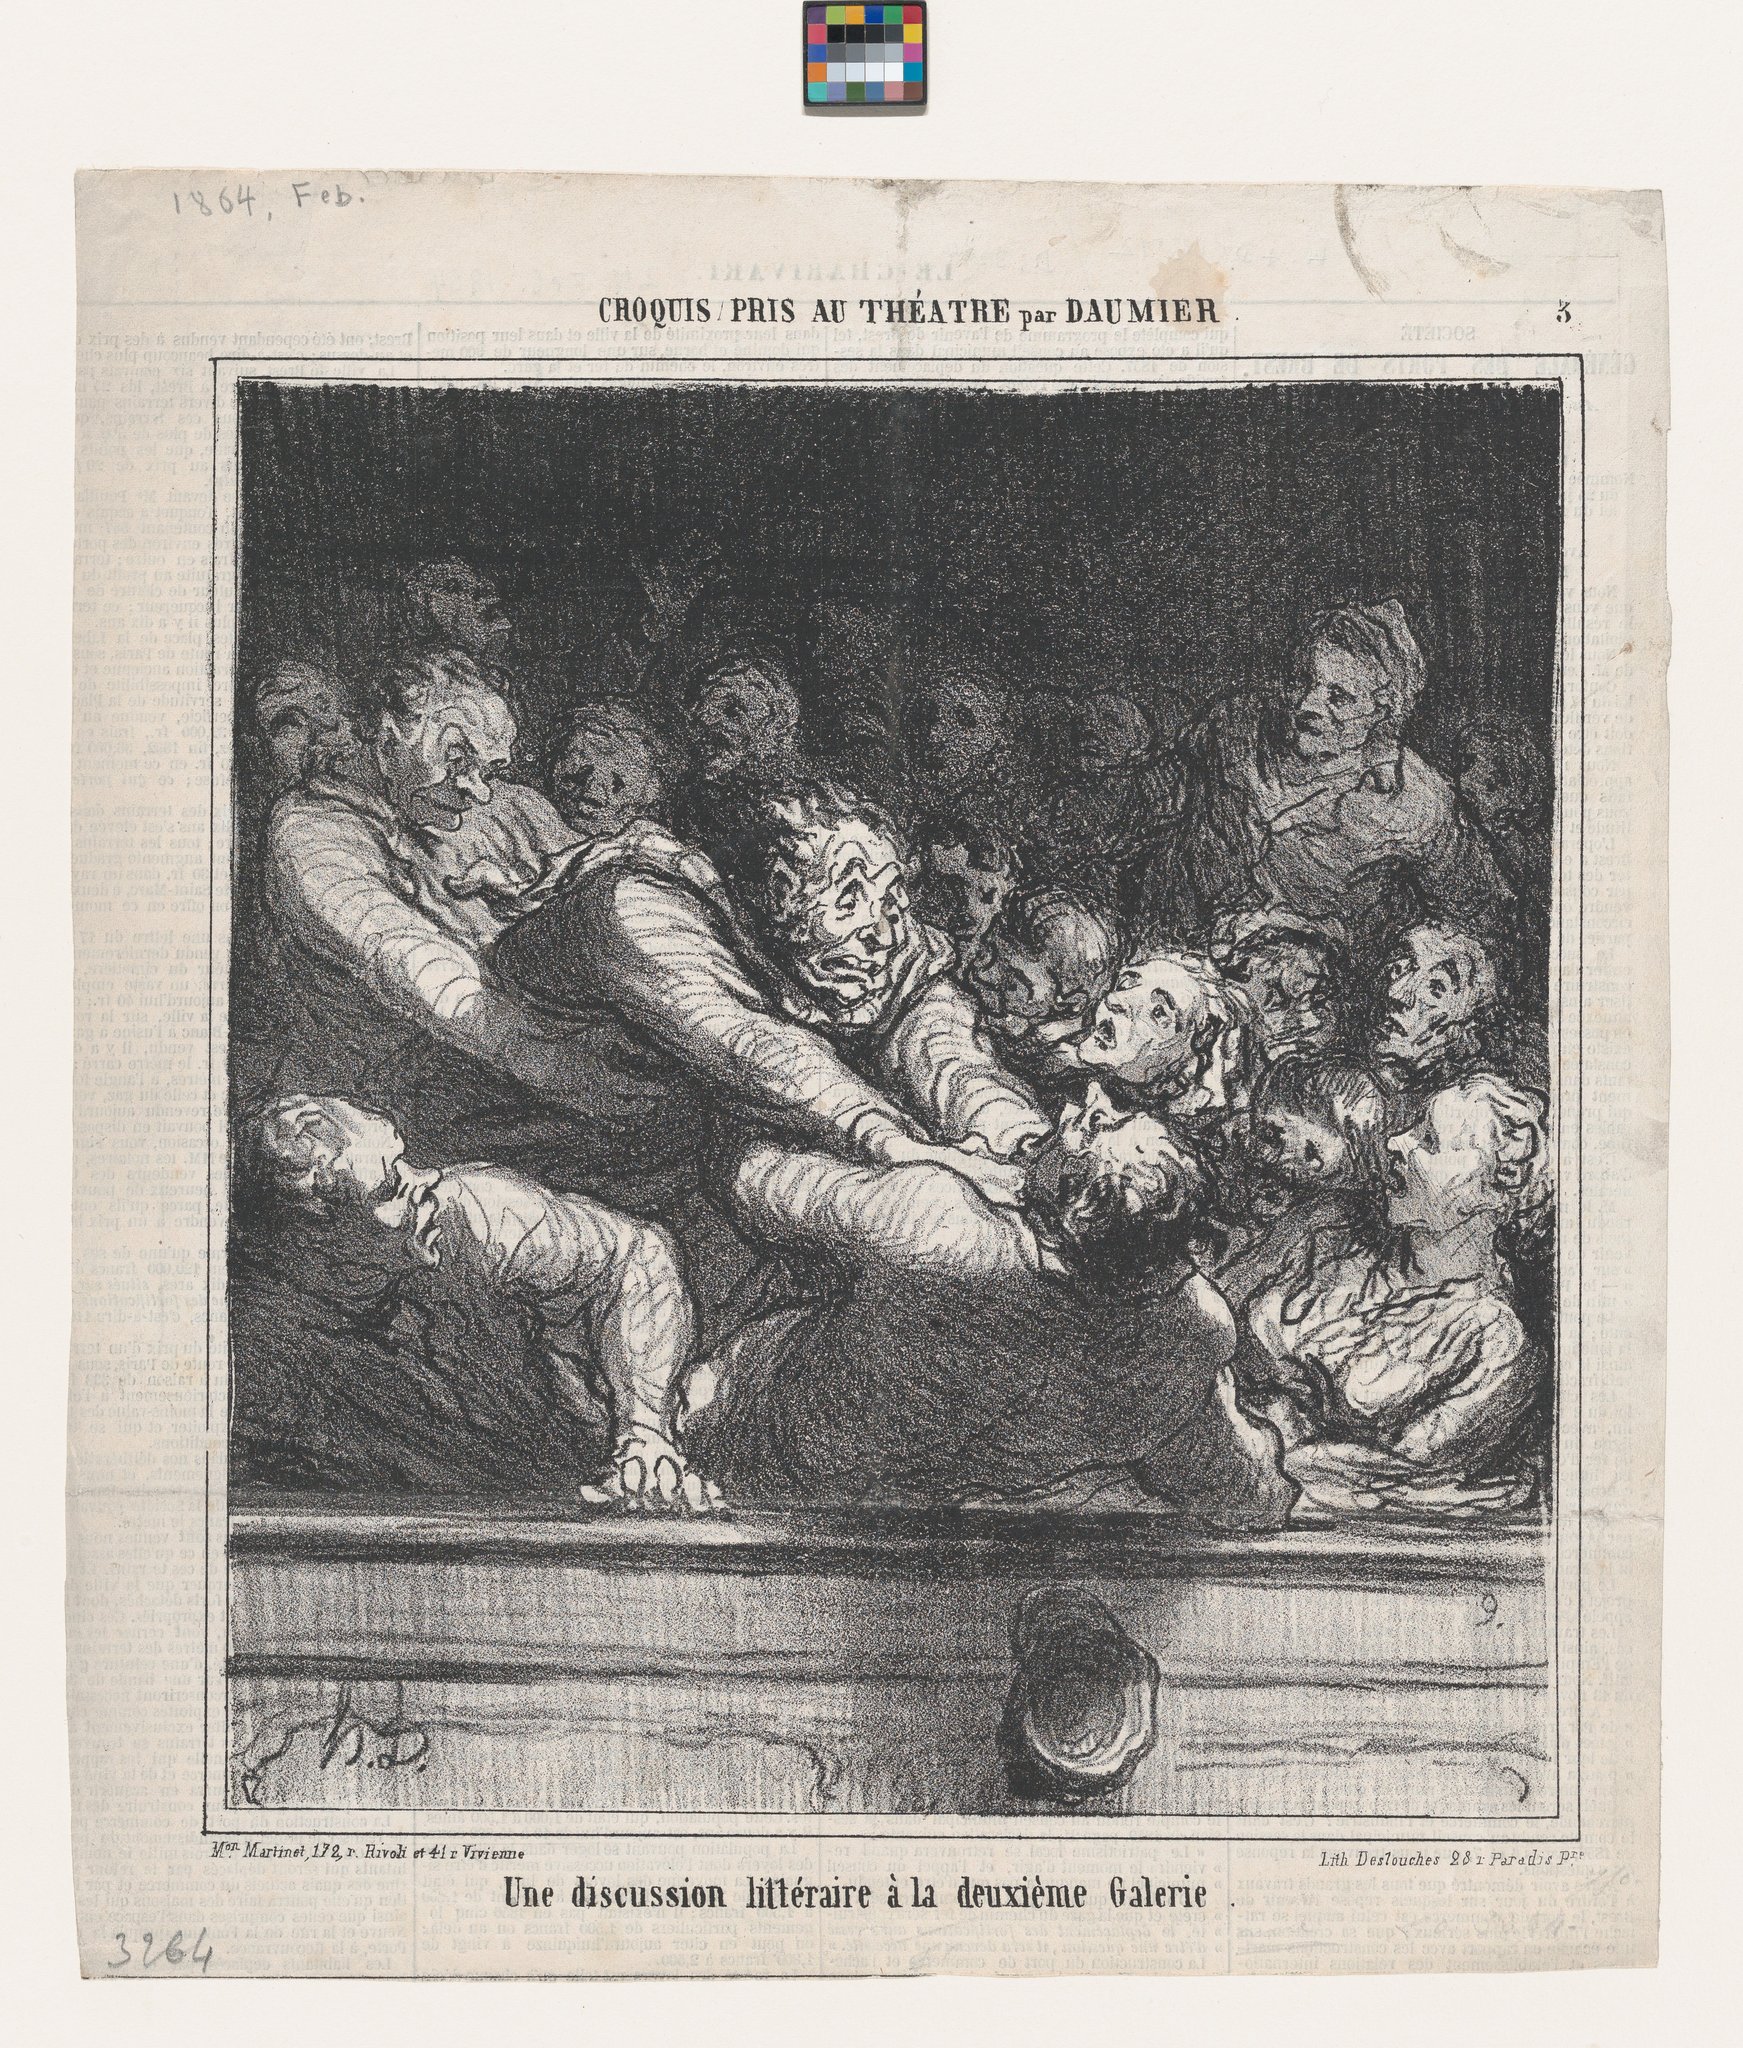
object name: print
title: A literary argument on the second tier, from 'Theater sketches,' published in Le Charivari, February 27, 1864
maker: honoré daumier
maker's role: artist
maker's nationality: french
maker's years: 1808-1879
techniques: lithograph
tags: satire,men,crowd